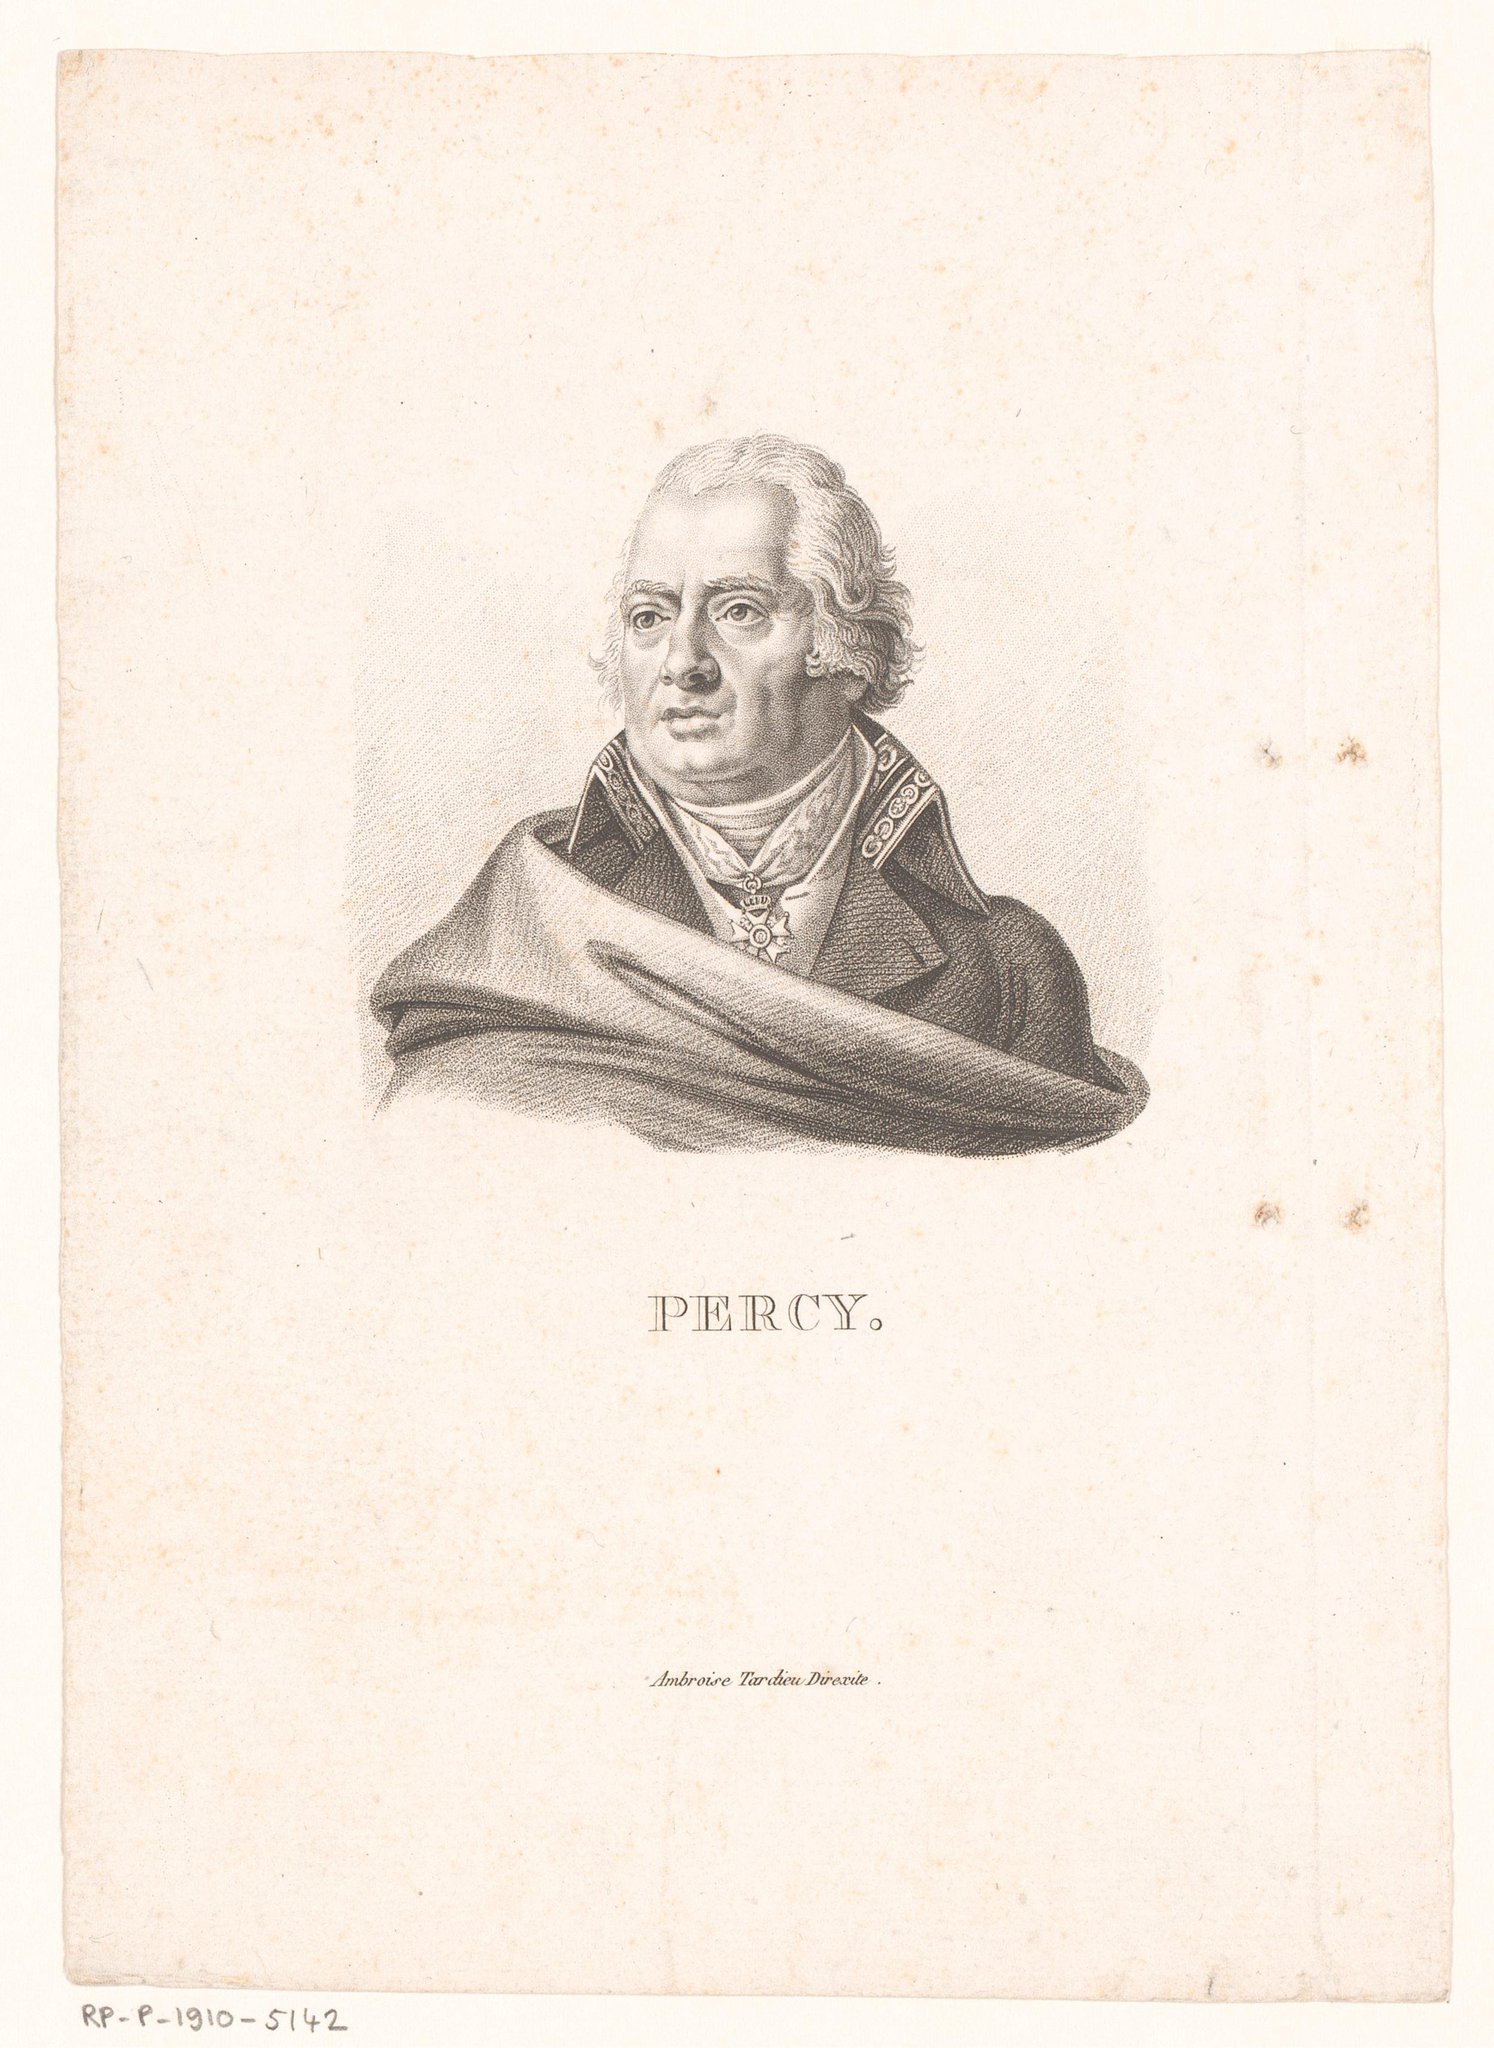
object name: print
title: Portret van Pierre-François Percy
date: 1818-1832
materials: paper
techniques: engraving, roulette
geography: france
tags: paris, historical persons, barber; surgeon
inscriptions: collector's mark: Lugt 2228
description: Mogelijk prent uit: Journal complémentaire du Dictionnaire des sciences médicales. Parijs: Panckoucke, Charles Louis Fleury, 1818-1832.